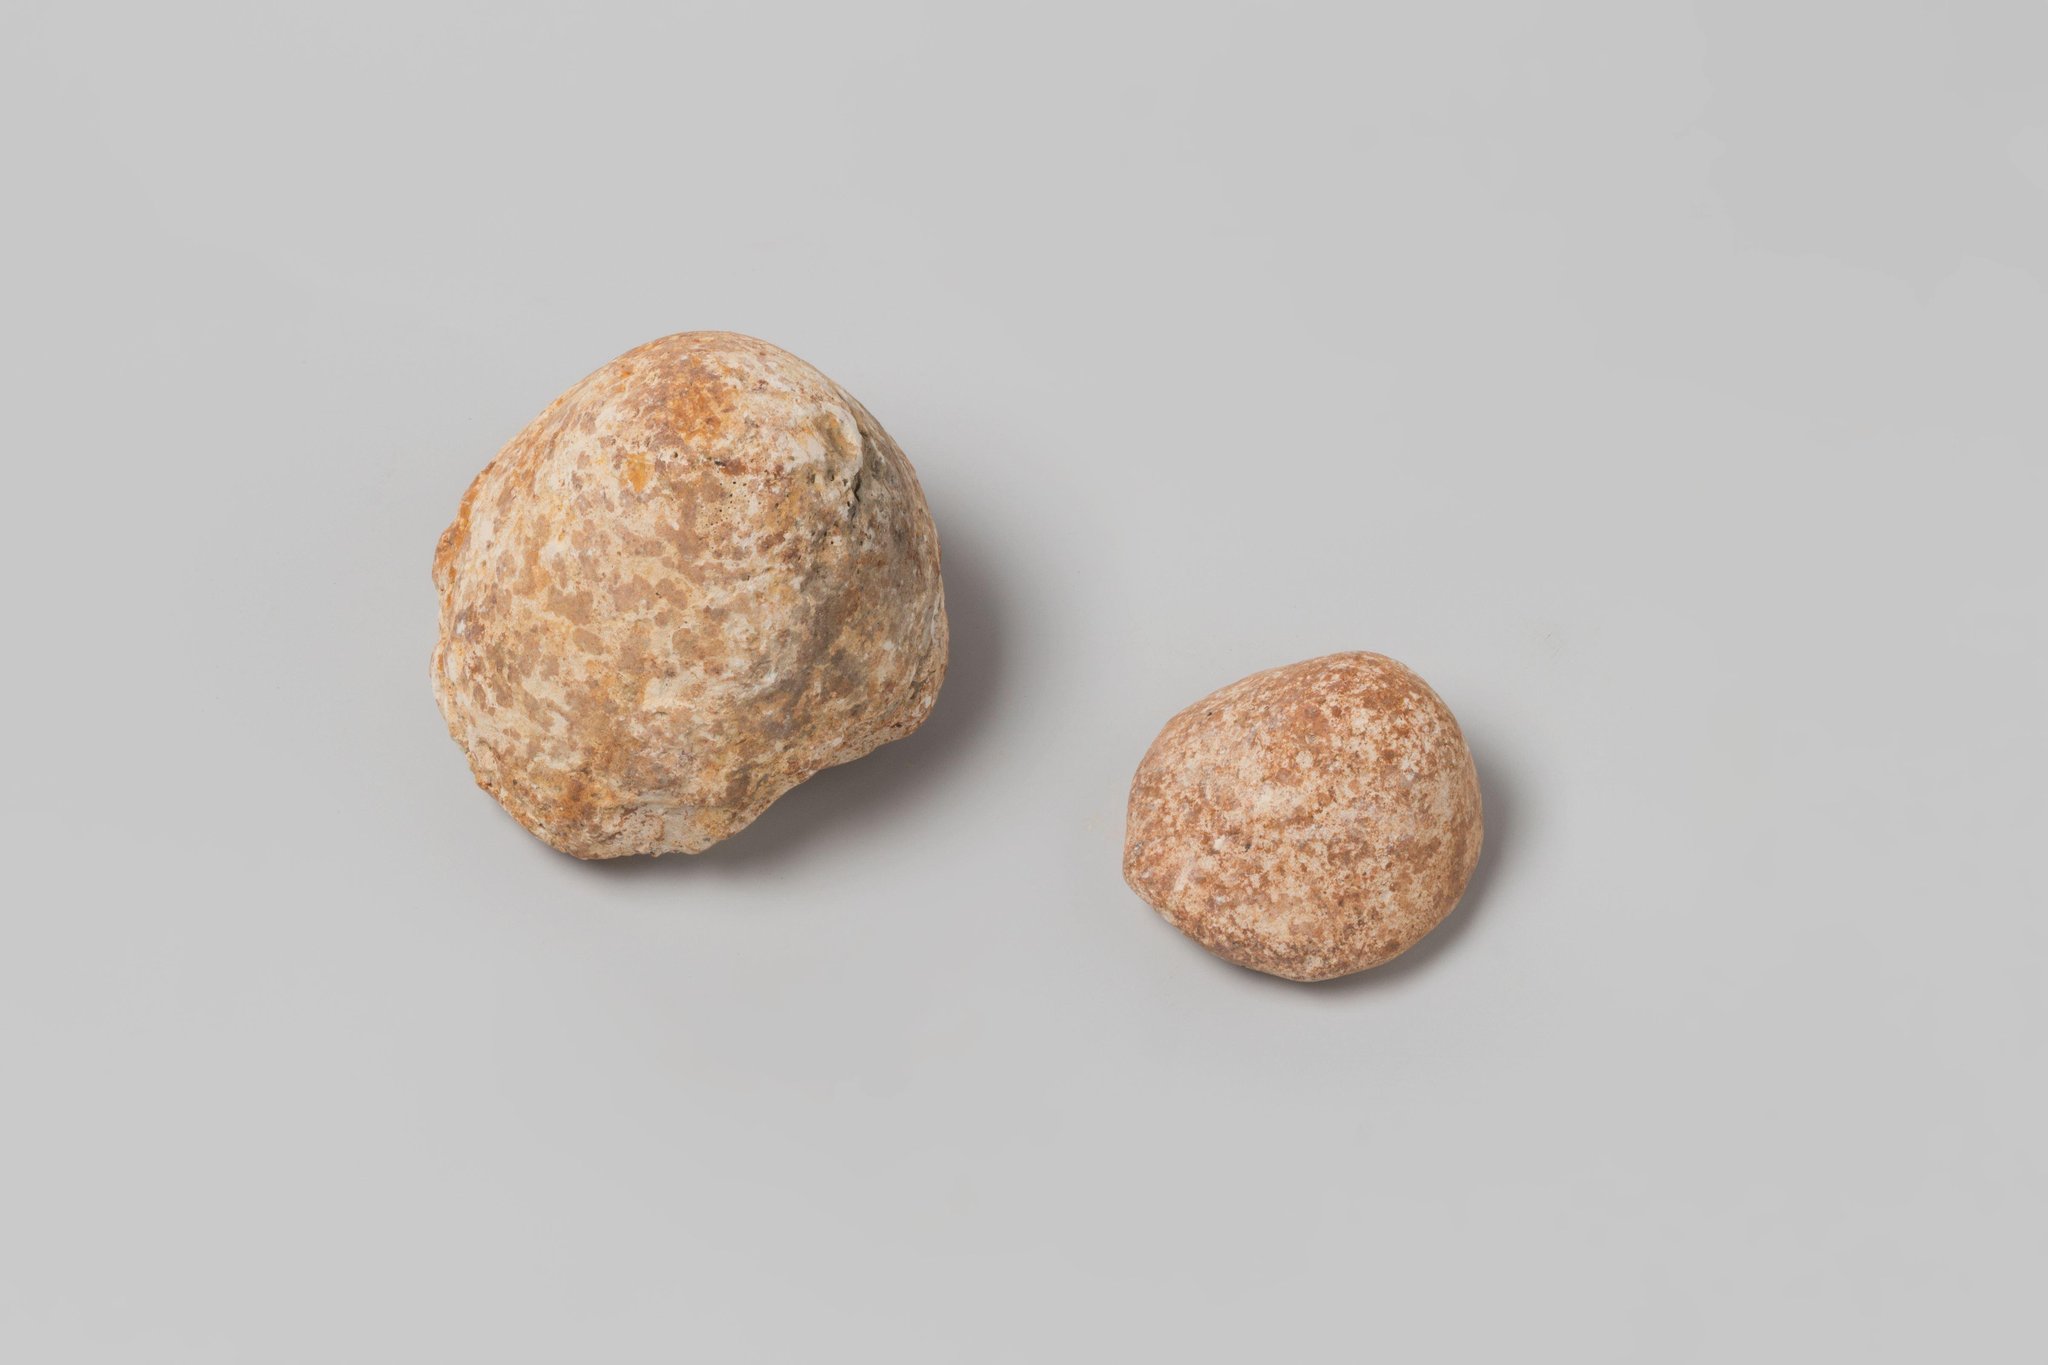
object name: scheepswrakvondst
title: Conische gipsfragmenten uit het wrak van de Oost-Indiëvaarder Hollandia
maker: Anonymous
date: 1700-1743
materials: gypsum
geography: netherlands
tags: verenigde oostindische compagnie, hollandia (schip), annet